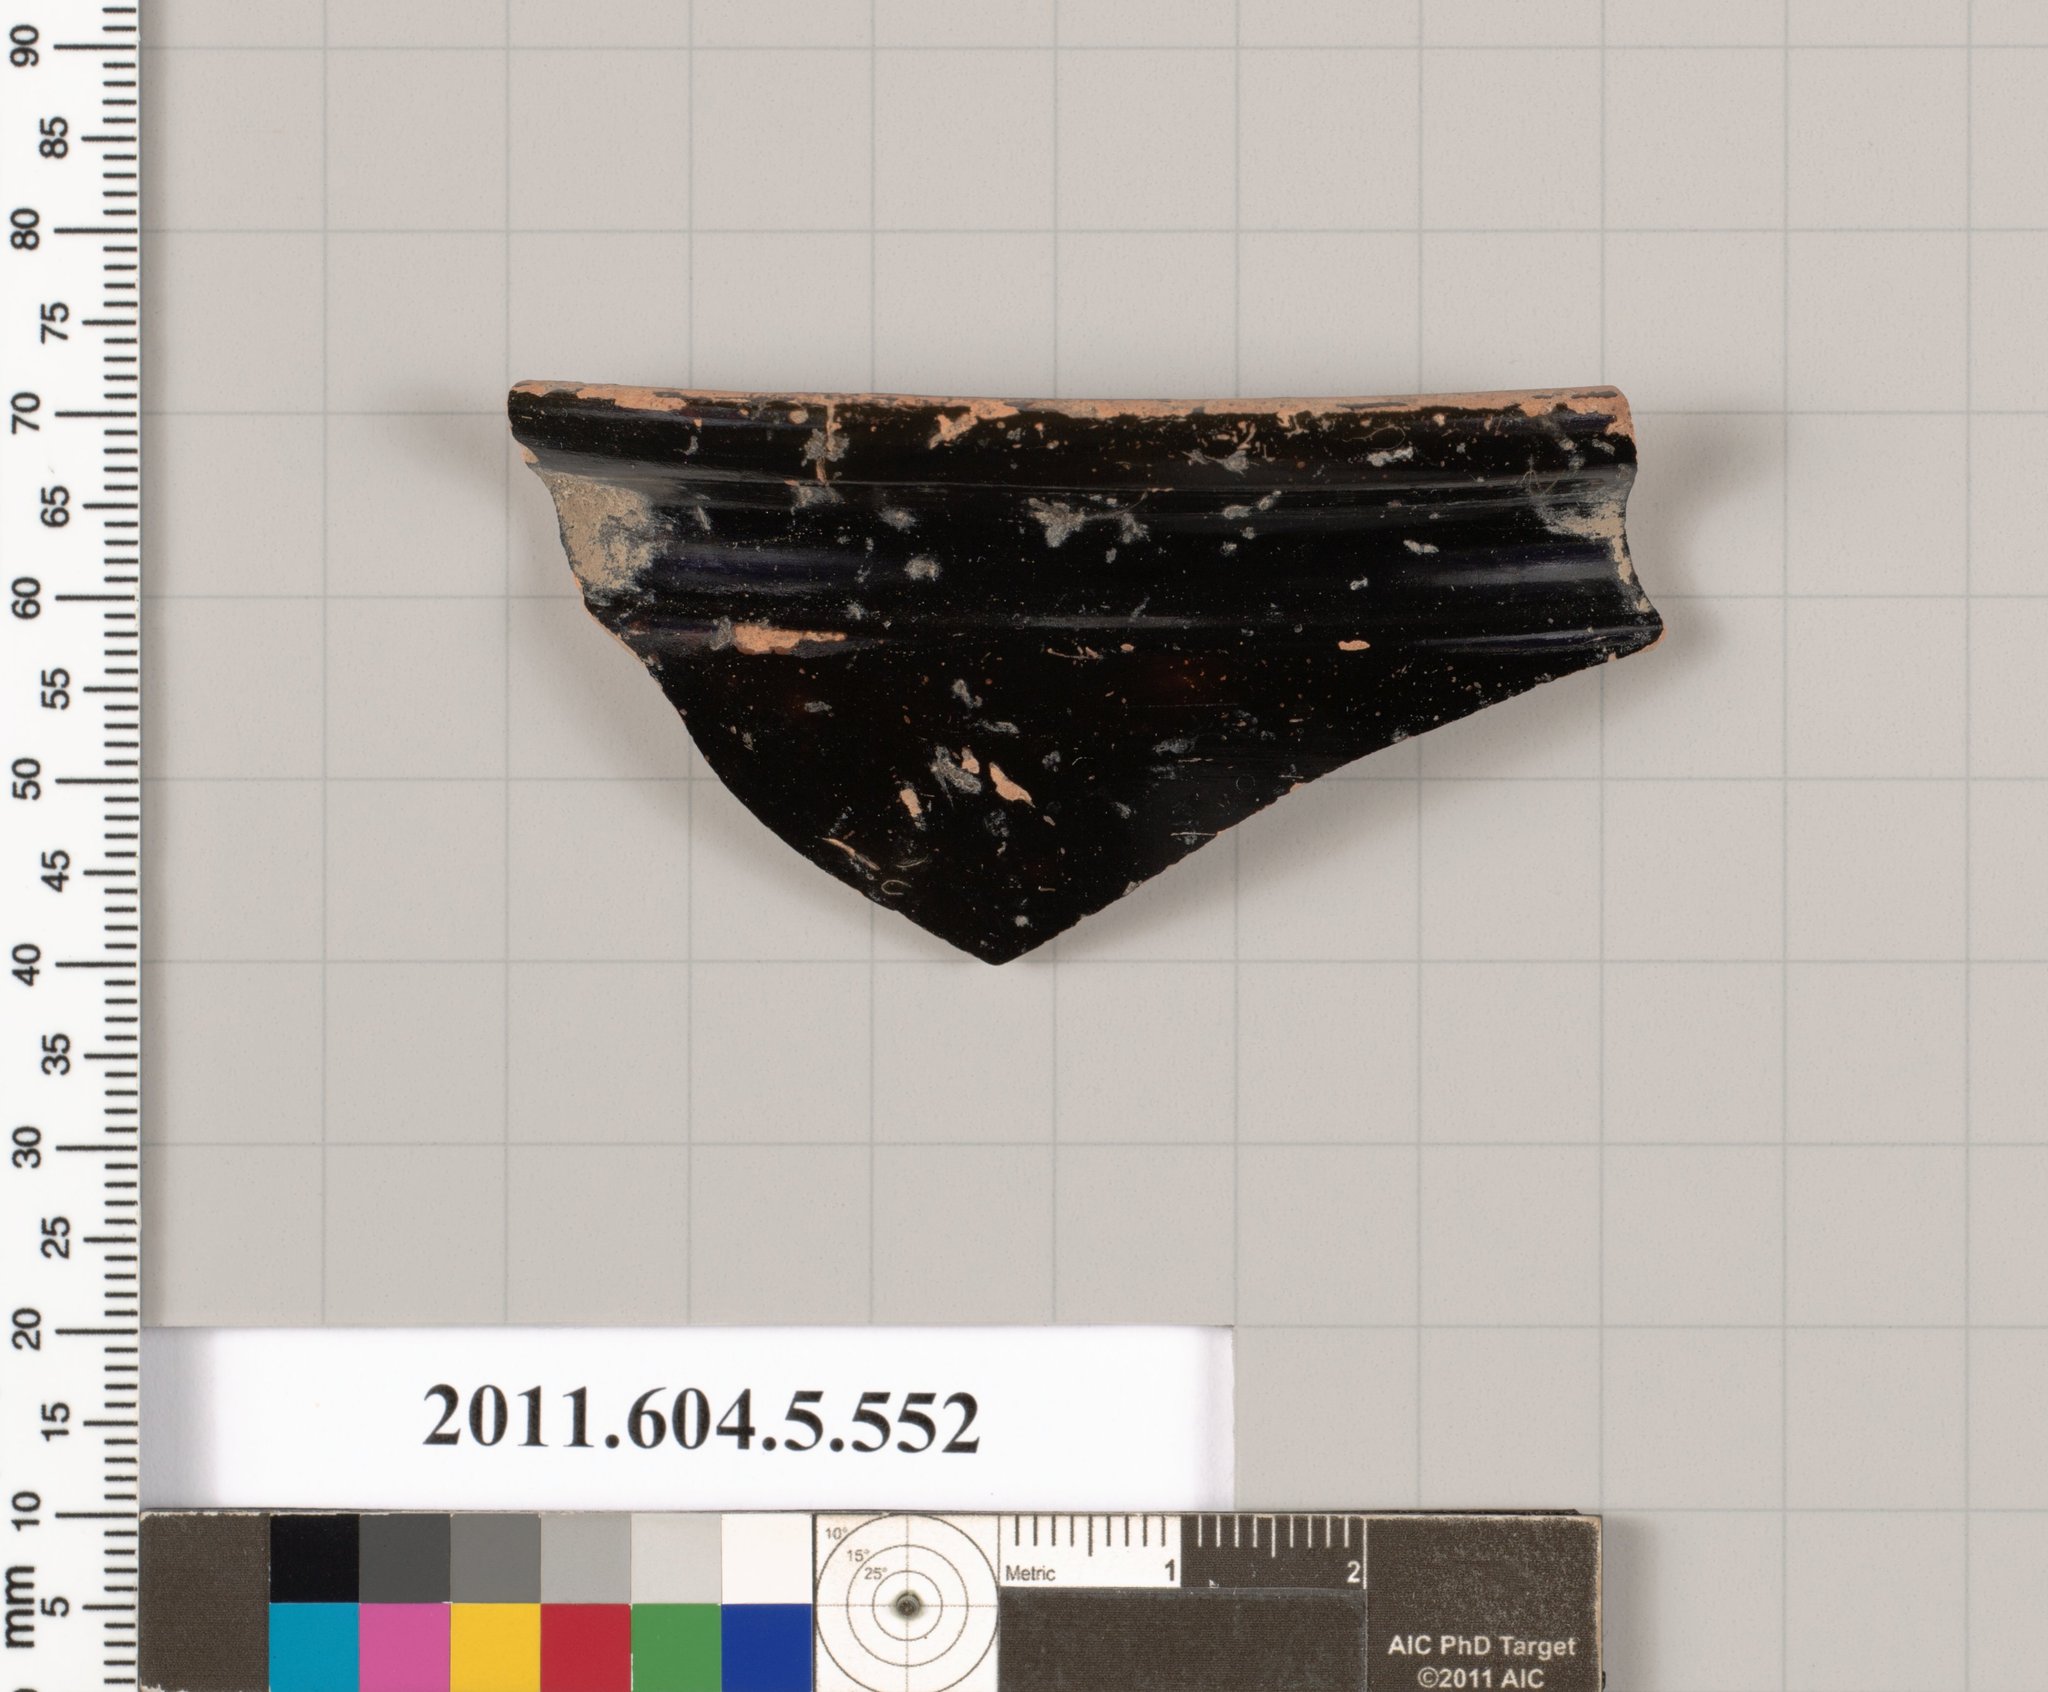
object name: cup skyphos fragment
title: Terracotta rim fragment of a cup-skyphos (drinking cup)?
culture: greek, attic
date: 500-401 BCE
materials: terracotta